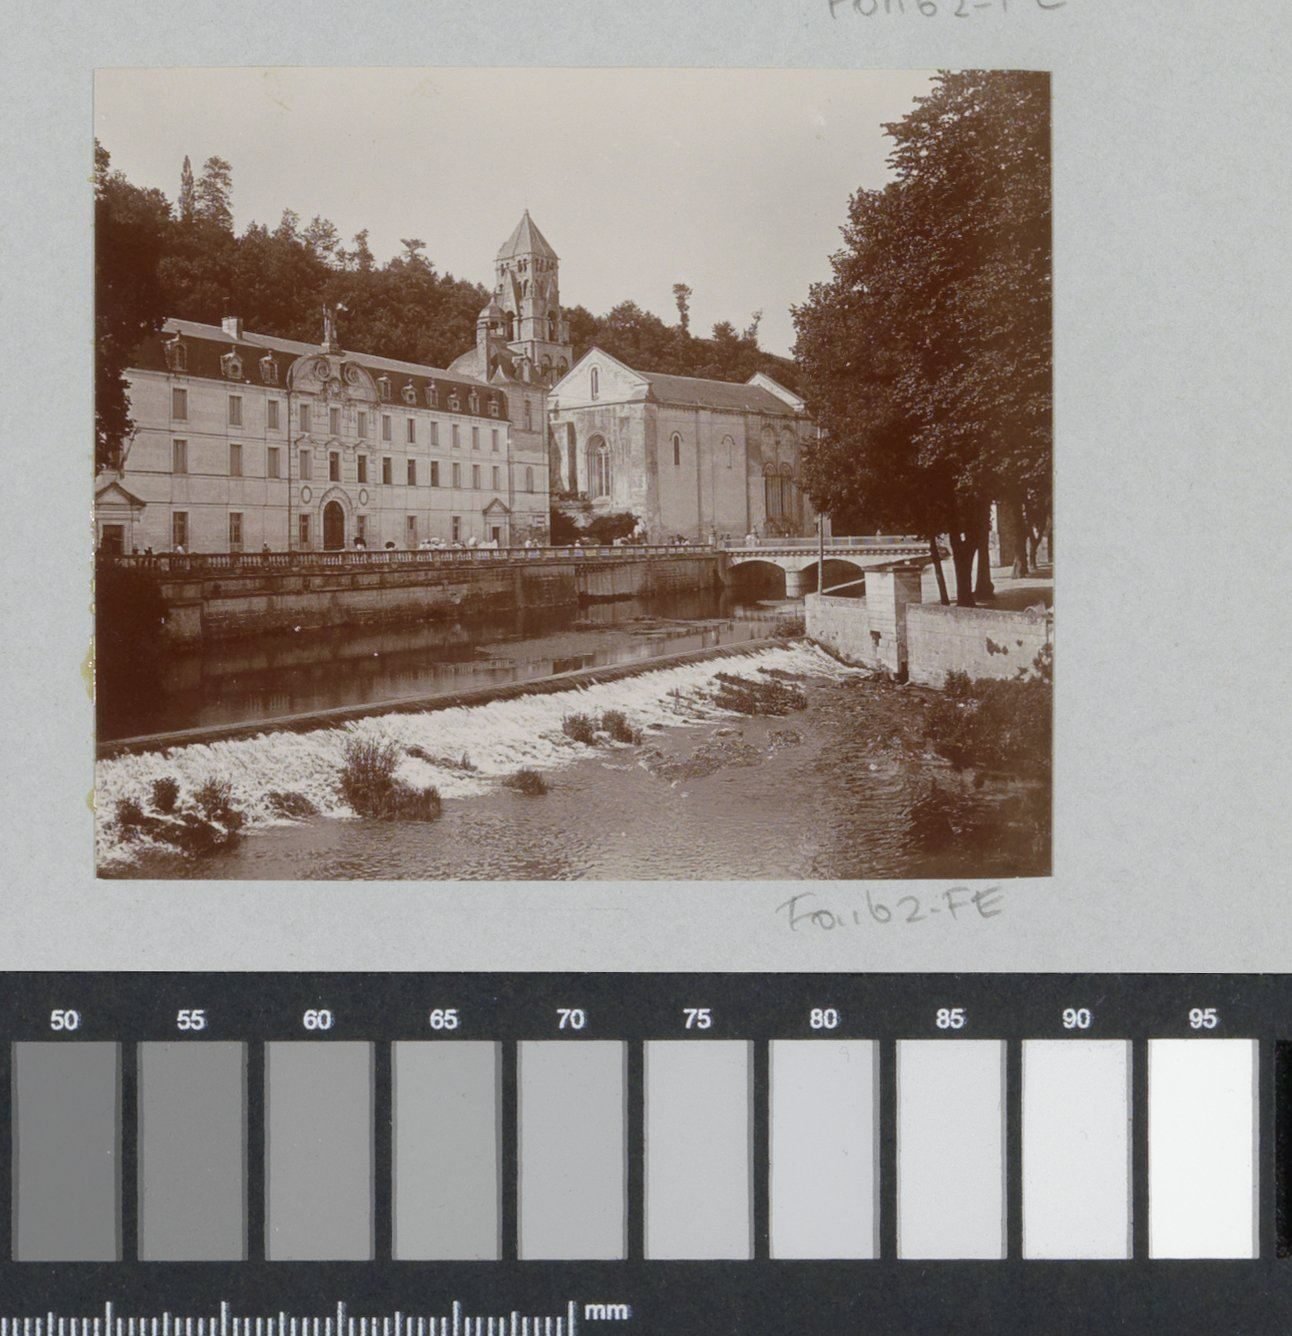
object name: photograph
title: Gezicht op een kerk, een stadspaleis en een stroomversnelling, vermoedelijk in een stad aan de Loire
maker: Anonymous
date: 1905-1910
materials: paper, photographic support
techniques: gelatin silver print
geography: france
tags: prospect of city, town panorama, silhouette of city, france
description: Onderdeel van Fotoalbum van een Franse amateurfotograaf met bezienswaardigheden in Frankrijk, Zwitserland en Italië.